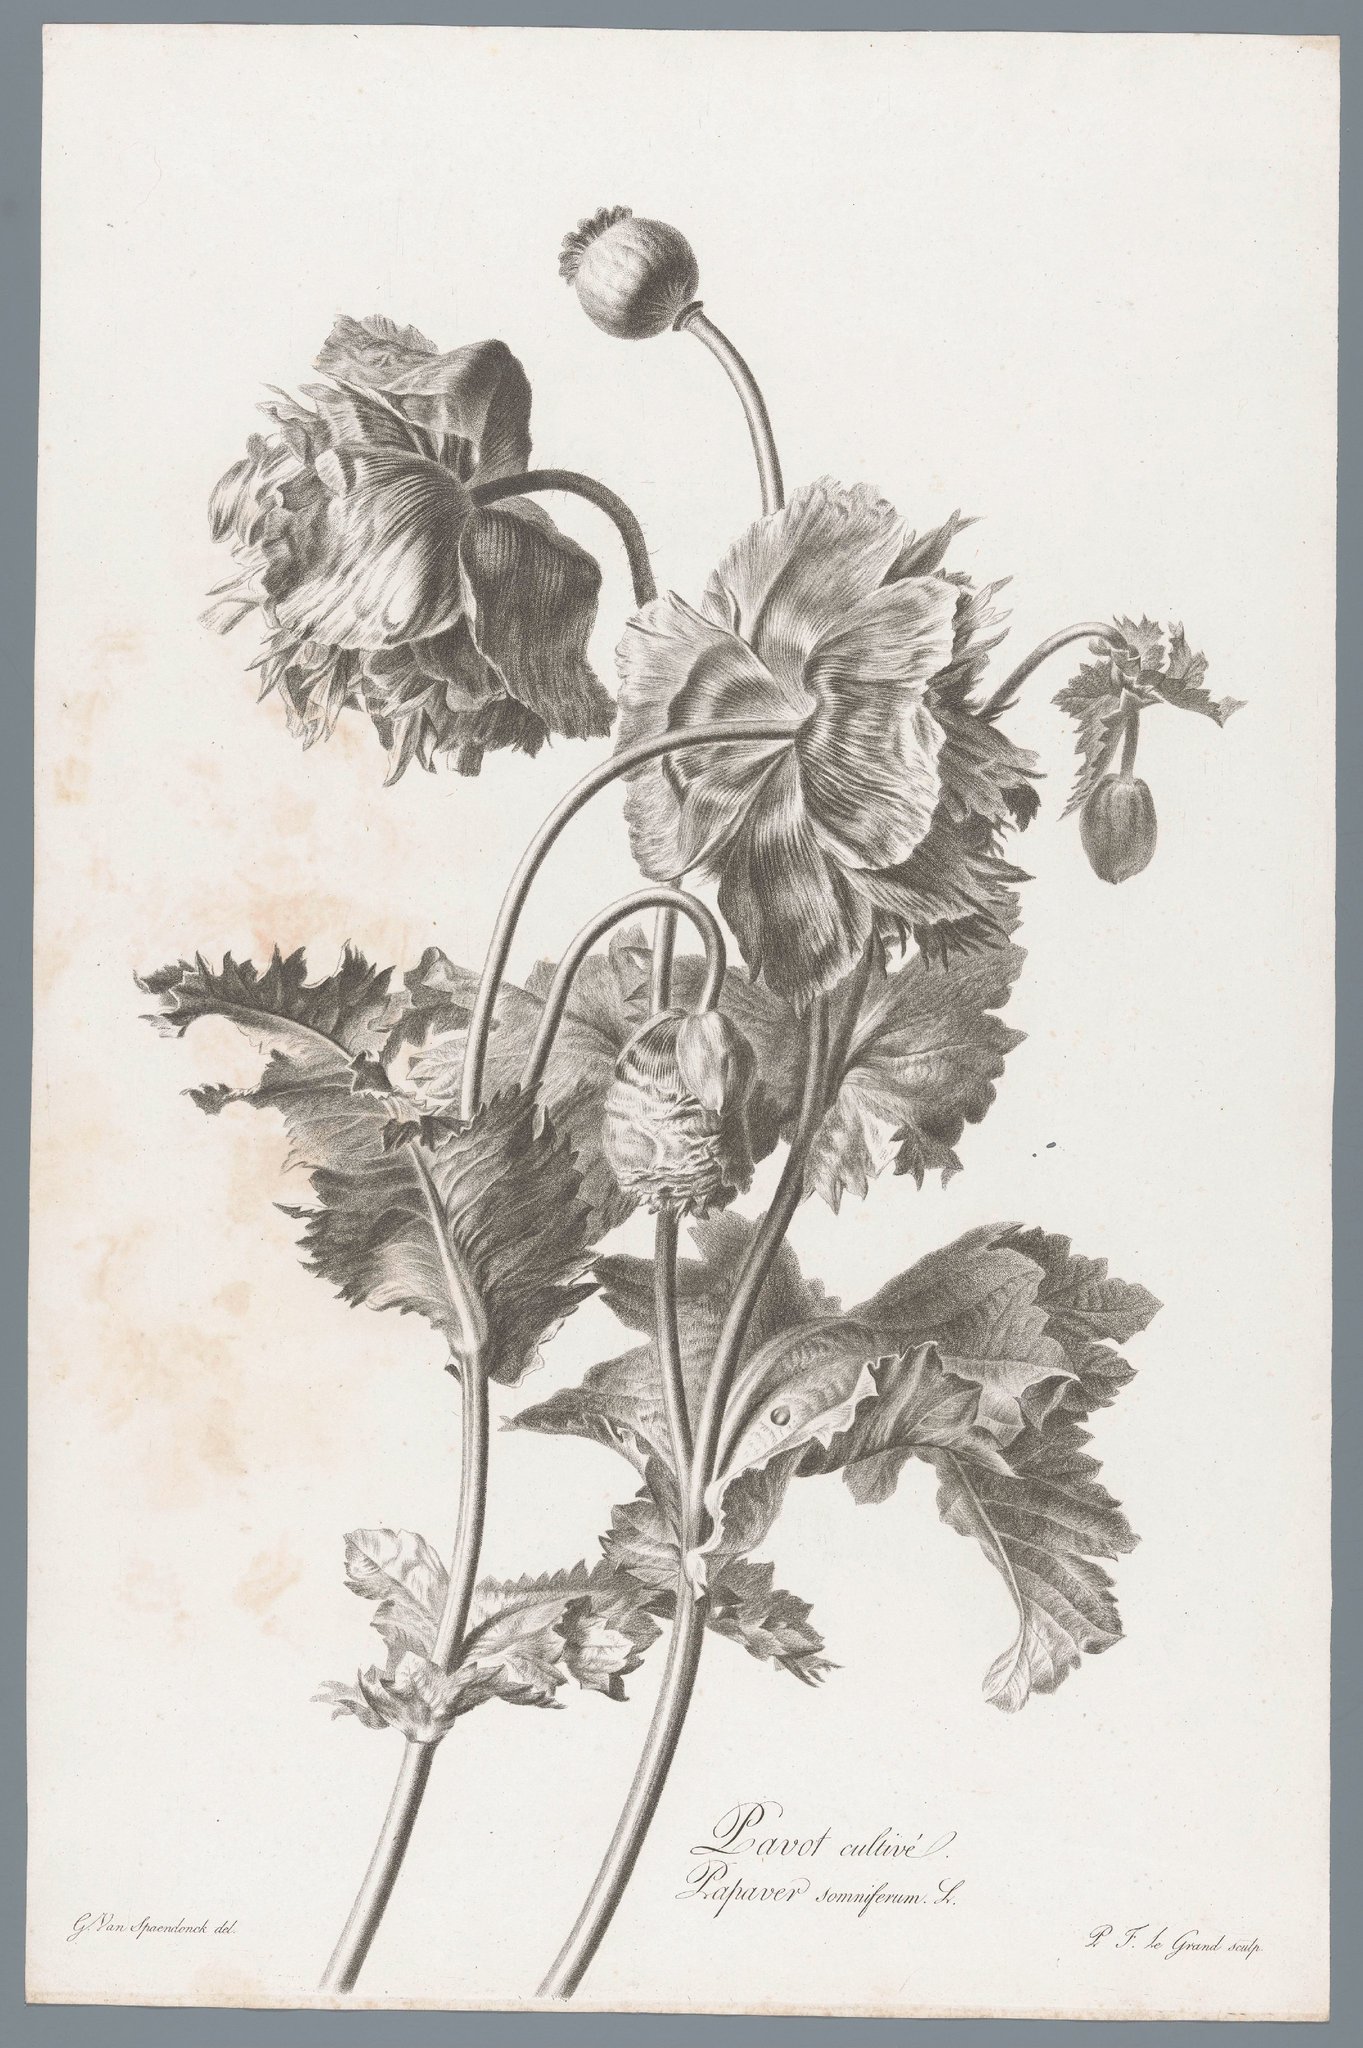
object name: ornament print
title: Fleurs dessinées d'après nature (...)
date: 1799-1801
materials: paper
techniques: engraving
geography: paris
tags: flowers: poppy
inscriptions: collector's mark: Lugt 2228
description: De serie Fleurs dessinées d'après nature (...) bestaat uit 24 prenten verdeeld over zes omslagen. Het Rijksprentenkabinet heeft 23 prenten in zes omslagen in bezit. De verdeling over de omslagen lijkt willekeurig. Zie RP-P-1909-4220 t/m 4242 en RP-P-2016-53 t/m 58.